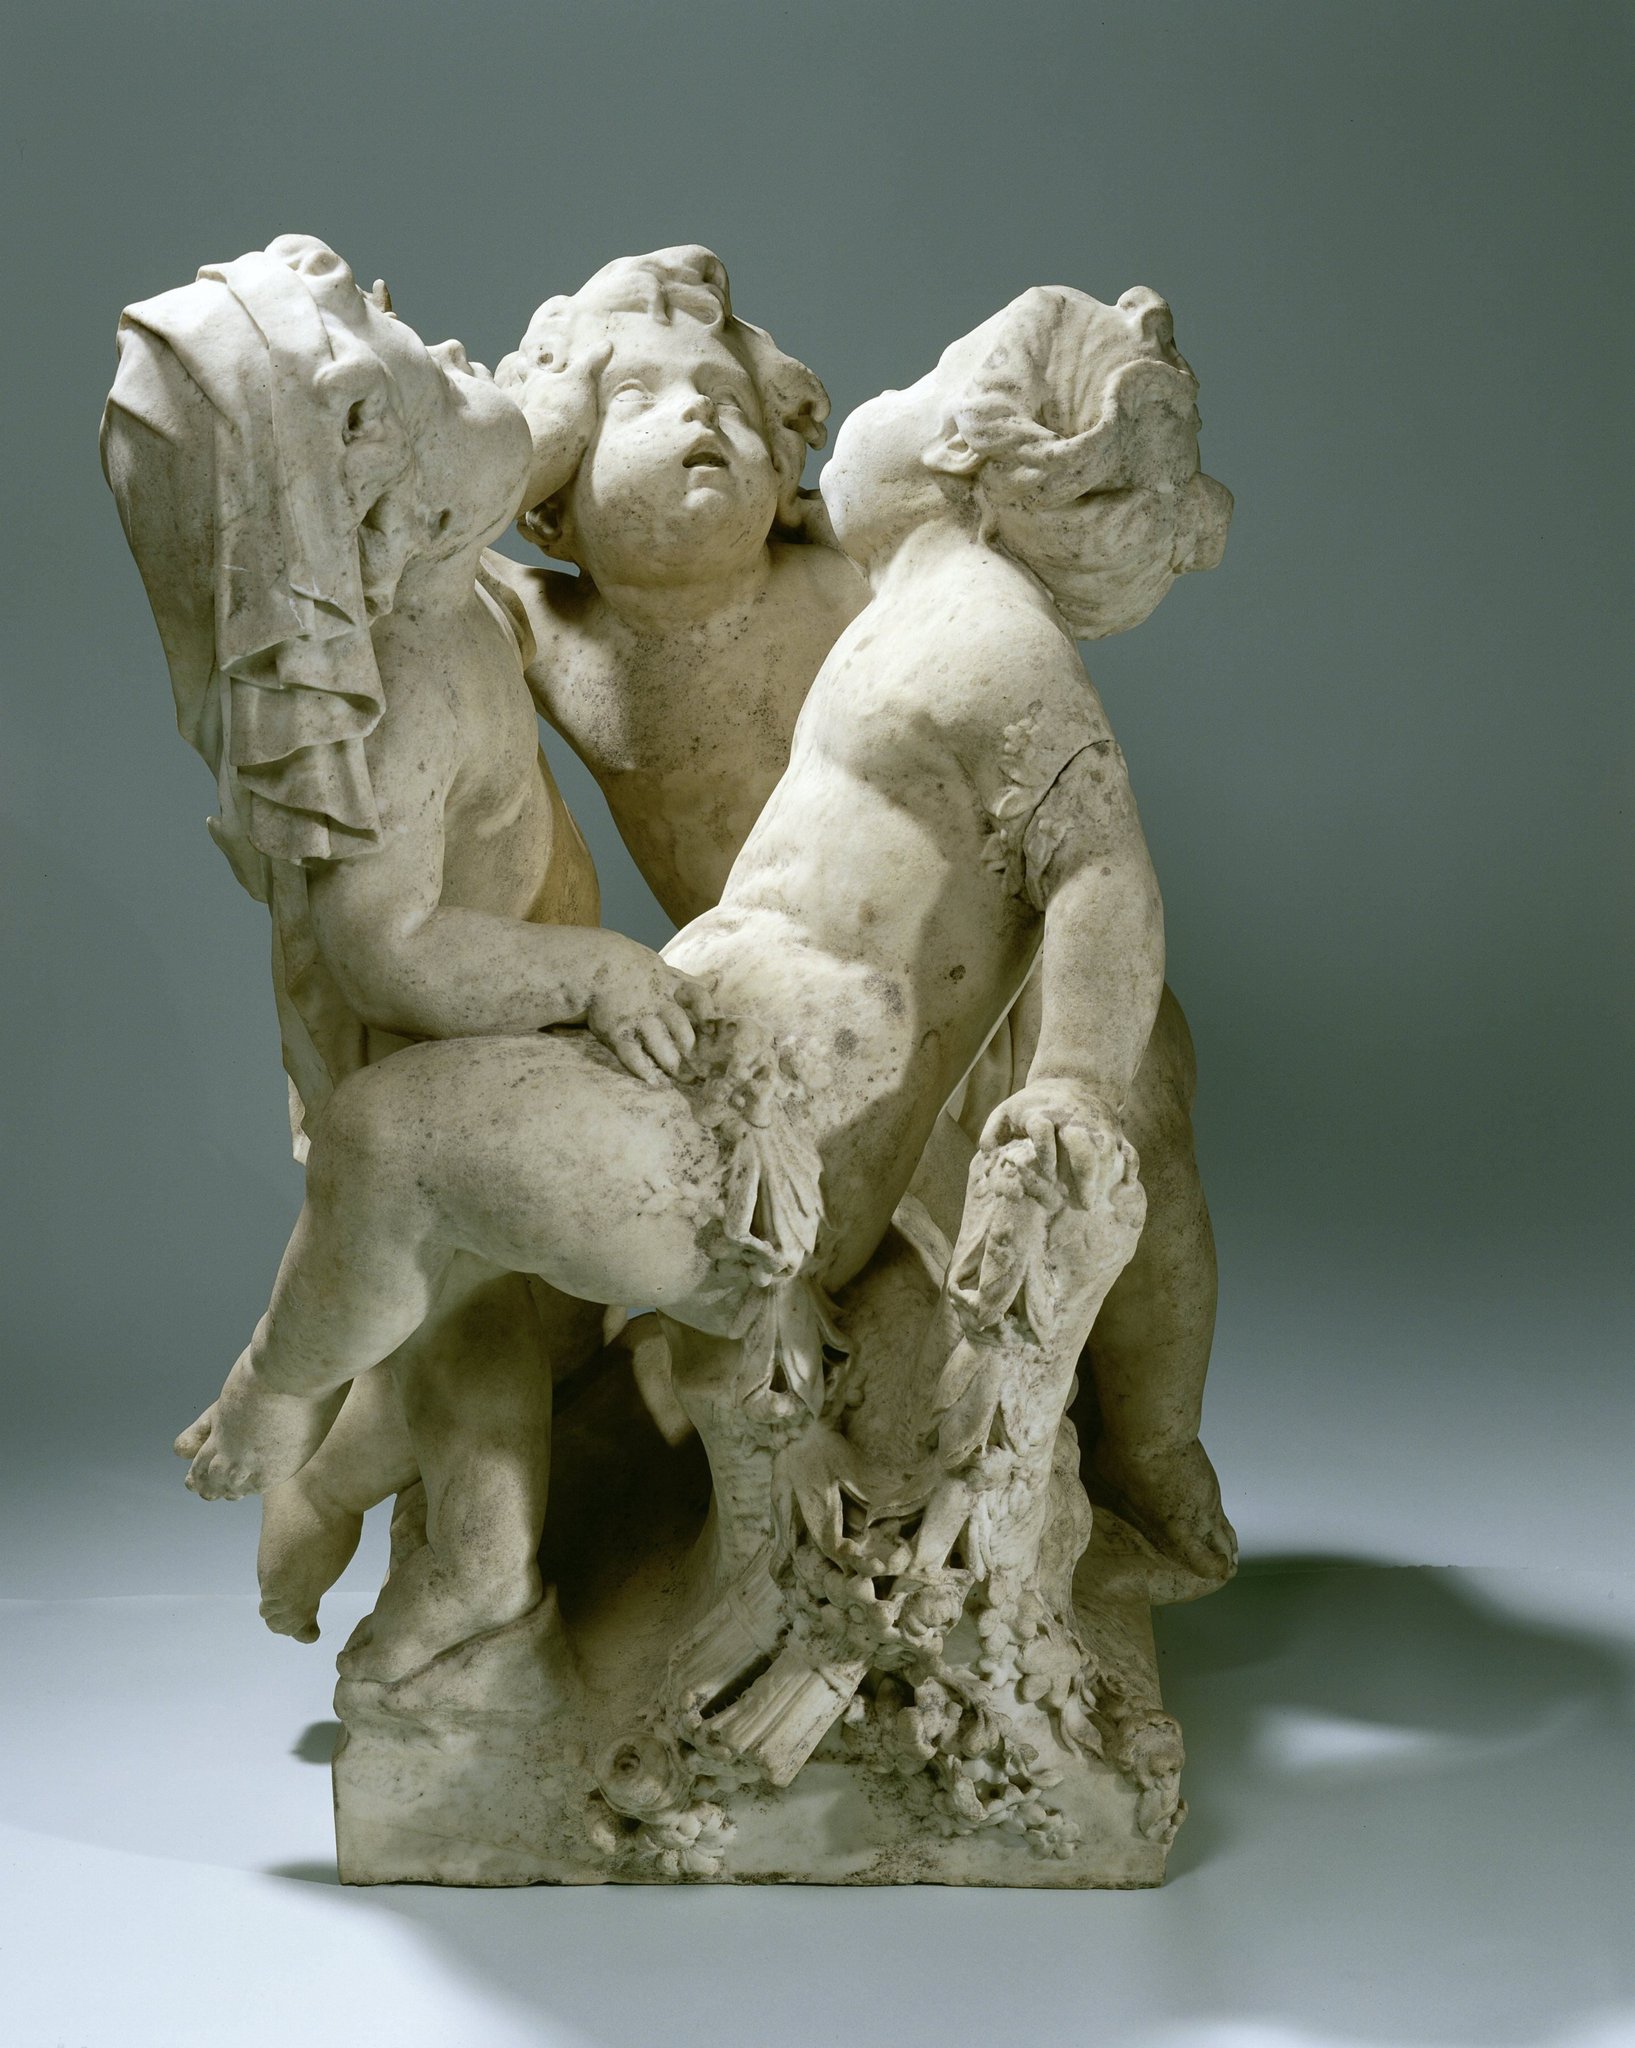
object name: tuinbeeld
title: Group of Three Quarrelling Children (Allegory of the Seasons ?)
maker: jan pieter van baurscheit (i)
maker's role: draughtsman, sculptor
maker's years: 1669-1728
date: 1726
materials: marble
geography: antwerp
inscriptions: signature and date, on the side of the plinth, incised: ‘PVB AURSCHEIT STATUARIUS CAESARIS I.F. 1726’ (PVB in ligature)